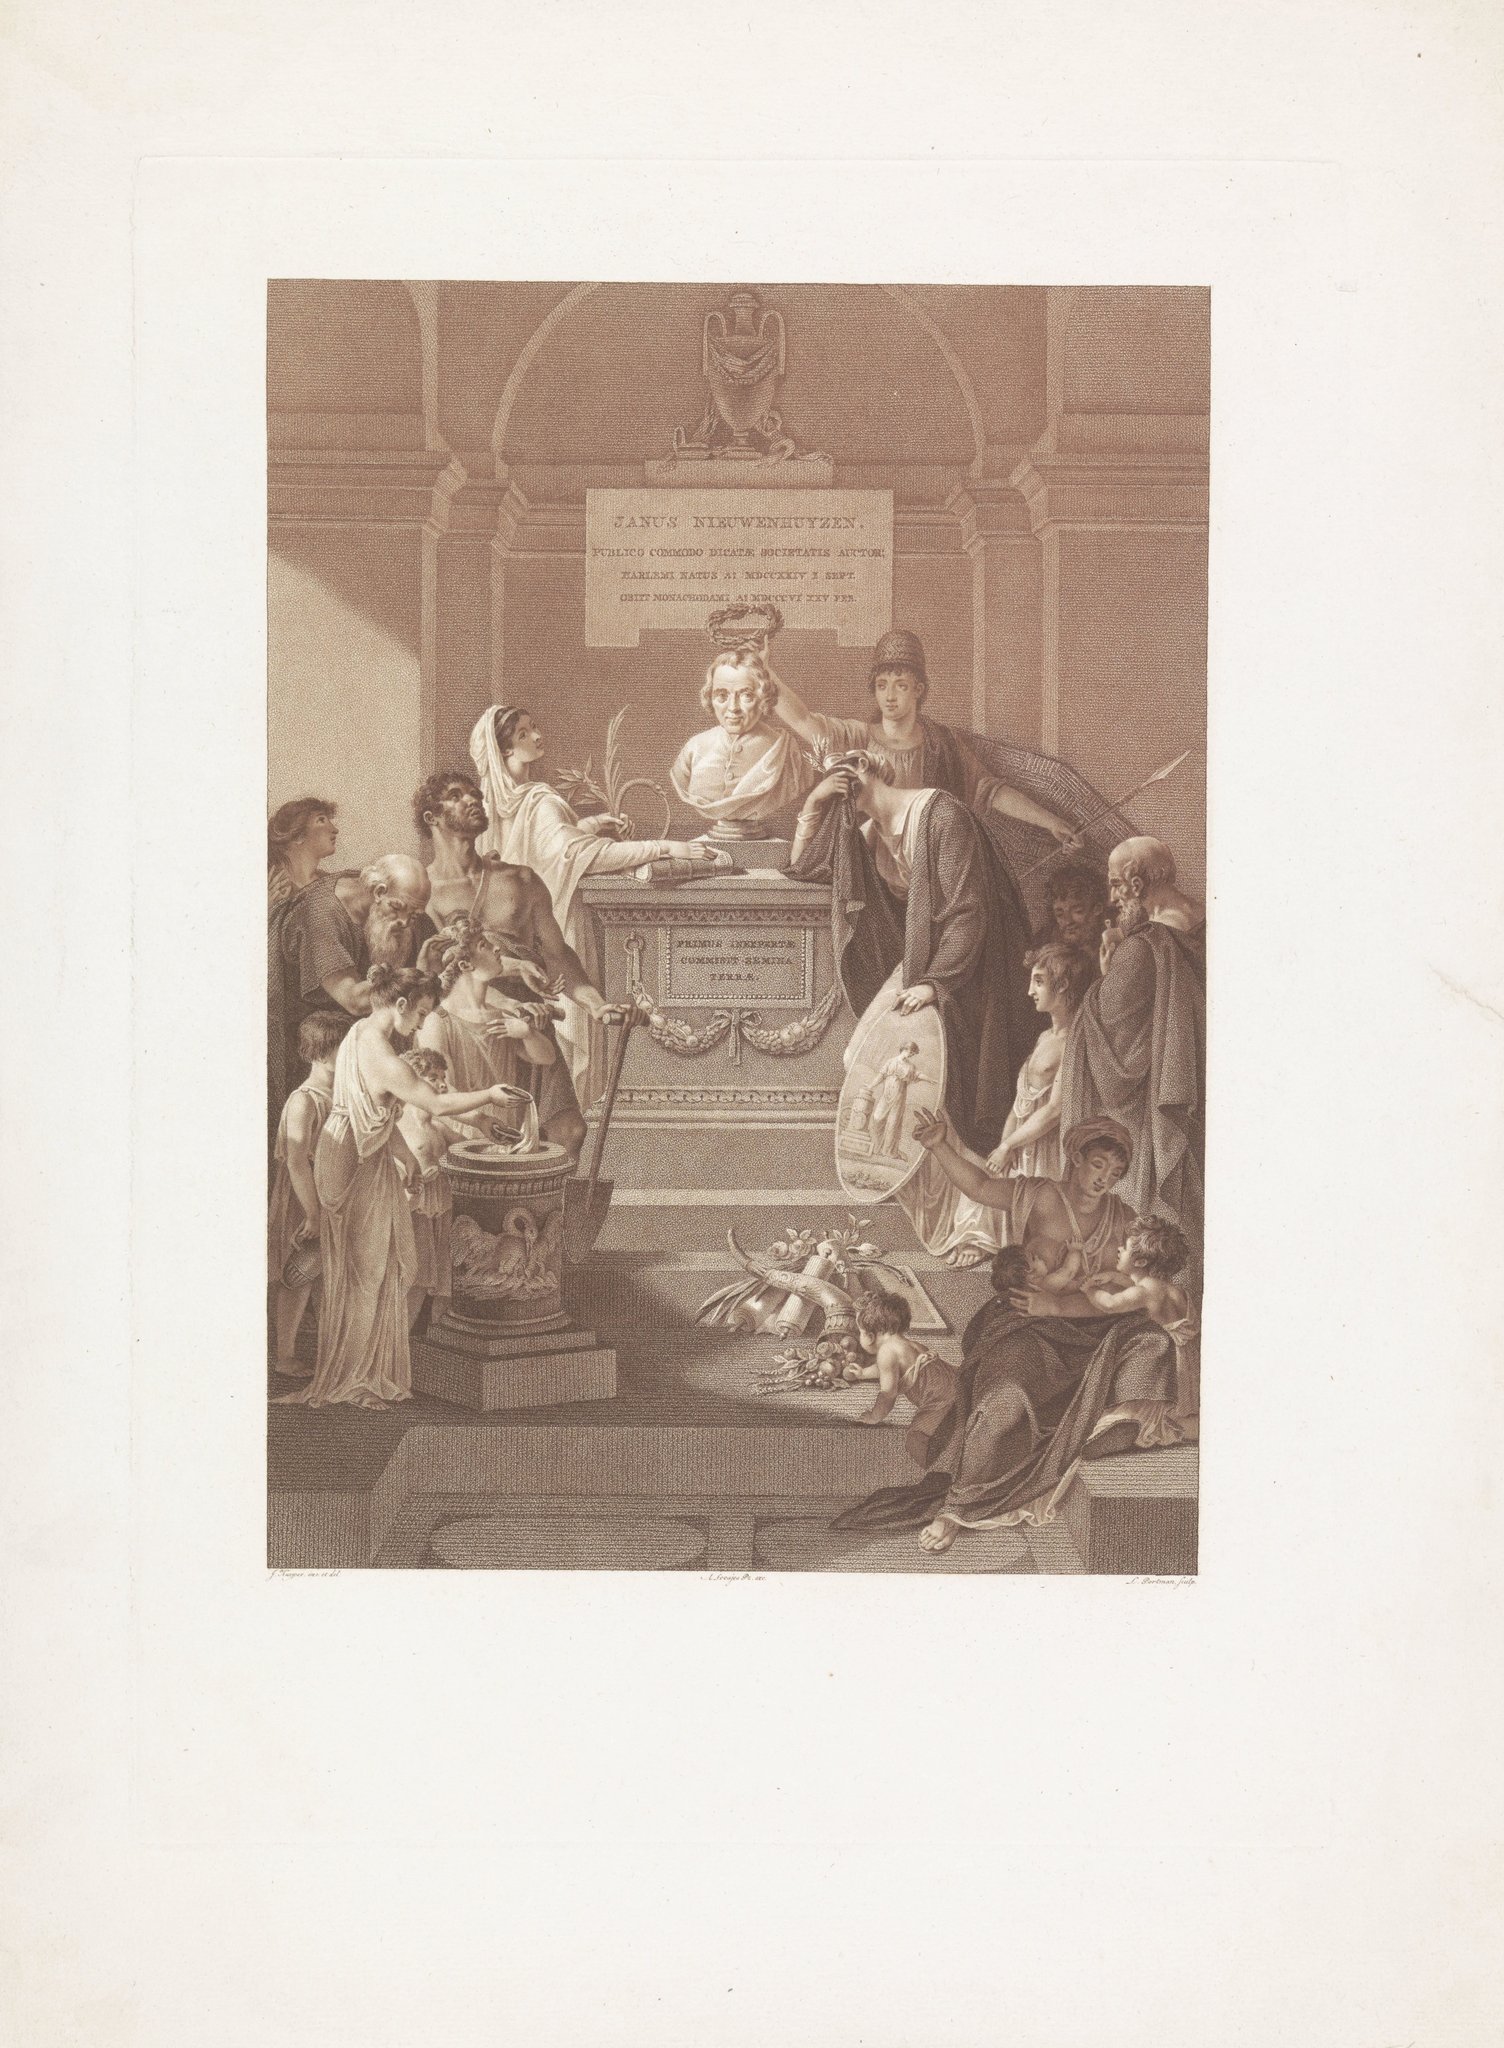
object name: print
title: Gedenkteken voor Jan Nieuwenhuyzen, 1806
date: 1806-1807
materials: paper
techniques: printing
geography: amsterdam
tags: haarlem, jan nieuwenhuyzen, personifications of countries, nations, states, districts, etc., grave-building, monumental tomb, netherlands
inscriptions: collector's mark: Lugt 2228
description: Allegorisch gedenkteken voor de op 24 februari 1806 overleden Jan Nieuwenhuyzen, oprichter van de Maatschappij tot Nut van 't Algemeen. Grafmonument met buste van de overledene, omringd door treurende allegorische figuren en andere personen. Rechts de personificatie van de Maatschappij met het schild van de Maatschappij. Op de achtergrond kroont de Nederlandse Maagd de buste met een krans van eikenloof.